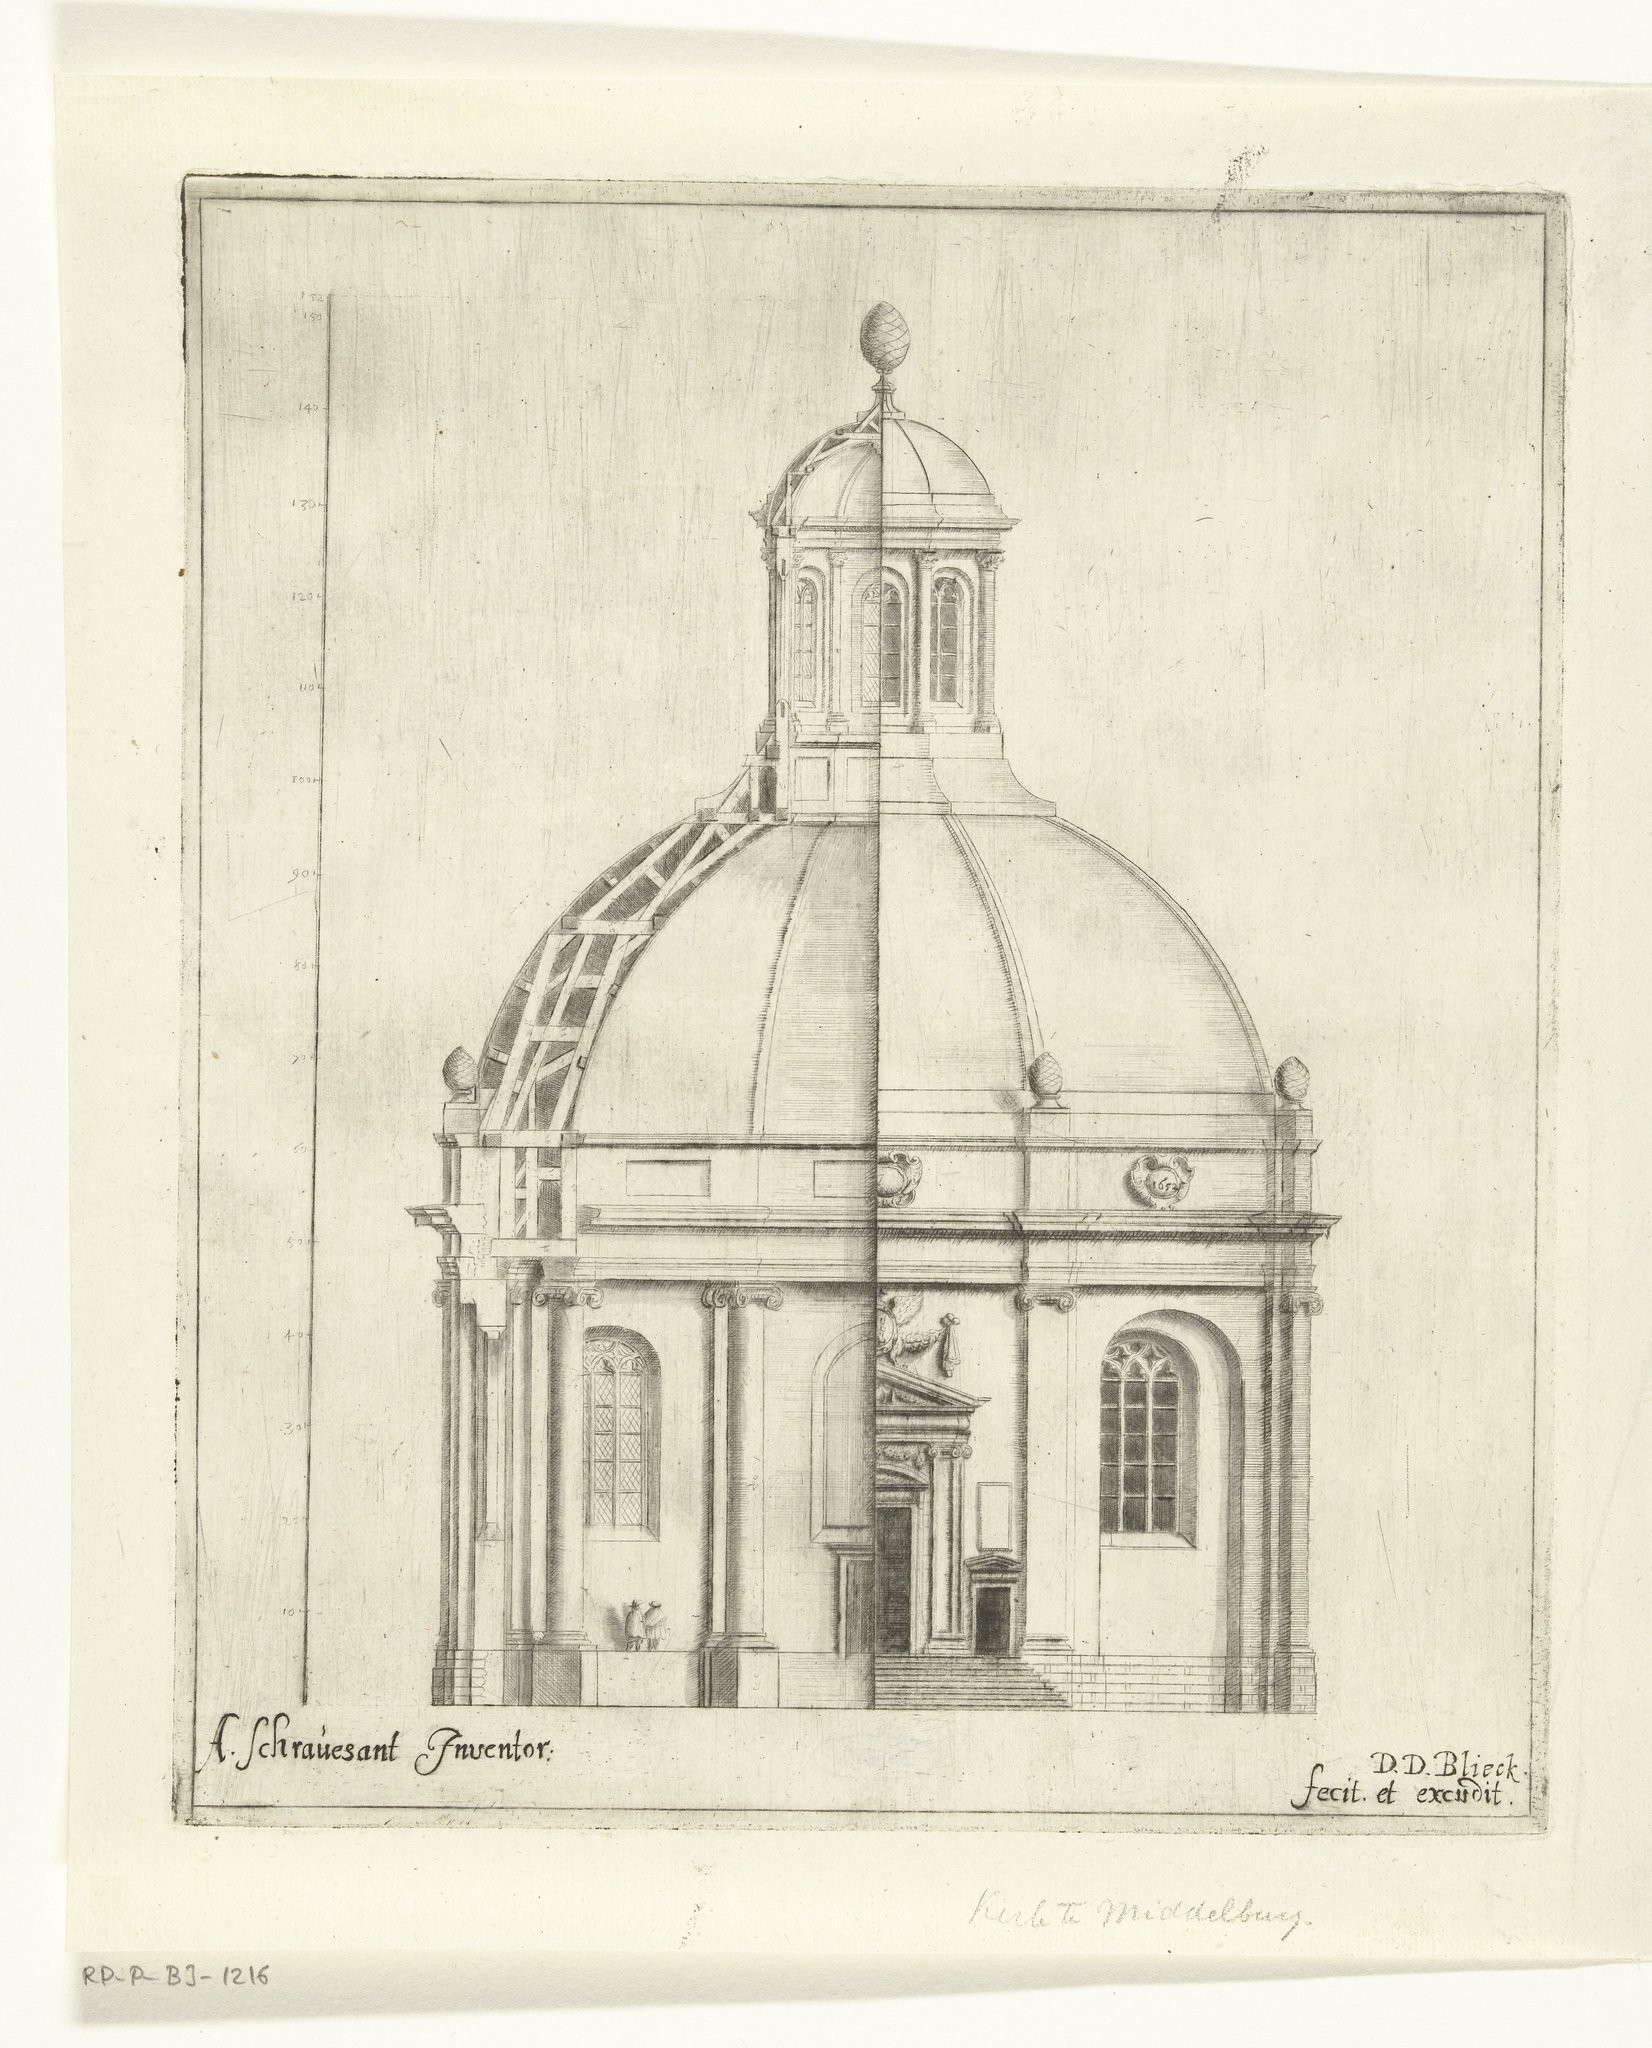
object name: print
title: Ontwerp voor de Oostkerk in Middelburg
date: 1652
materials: paper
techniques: drypoint, etching, hand coloring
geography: middelburg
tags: parts of church interior, parts of church exterior and annexes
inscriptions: collector's mark: Lugt 2228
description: Ontwerp voor de Oostkerk in Middelburg, waarbij zowel het interieur als het exterieur getoond wordt.